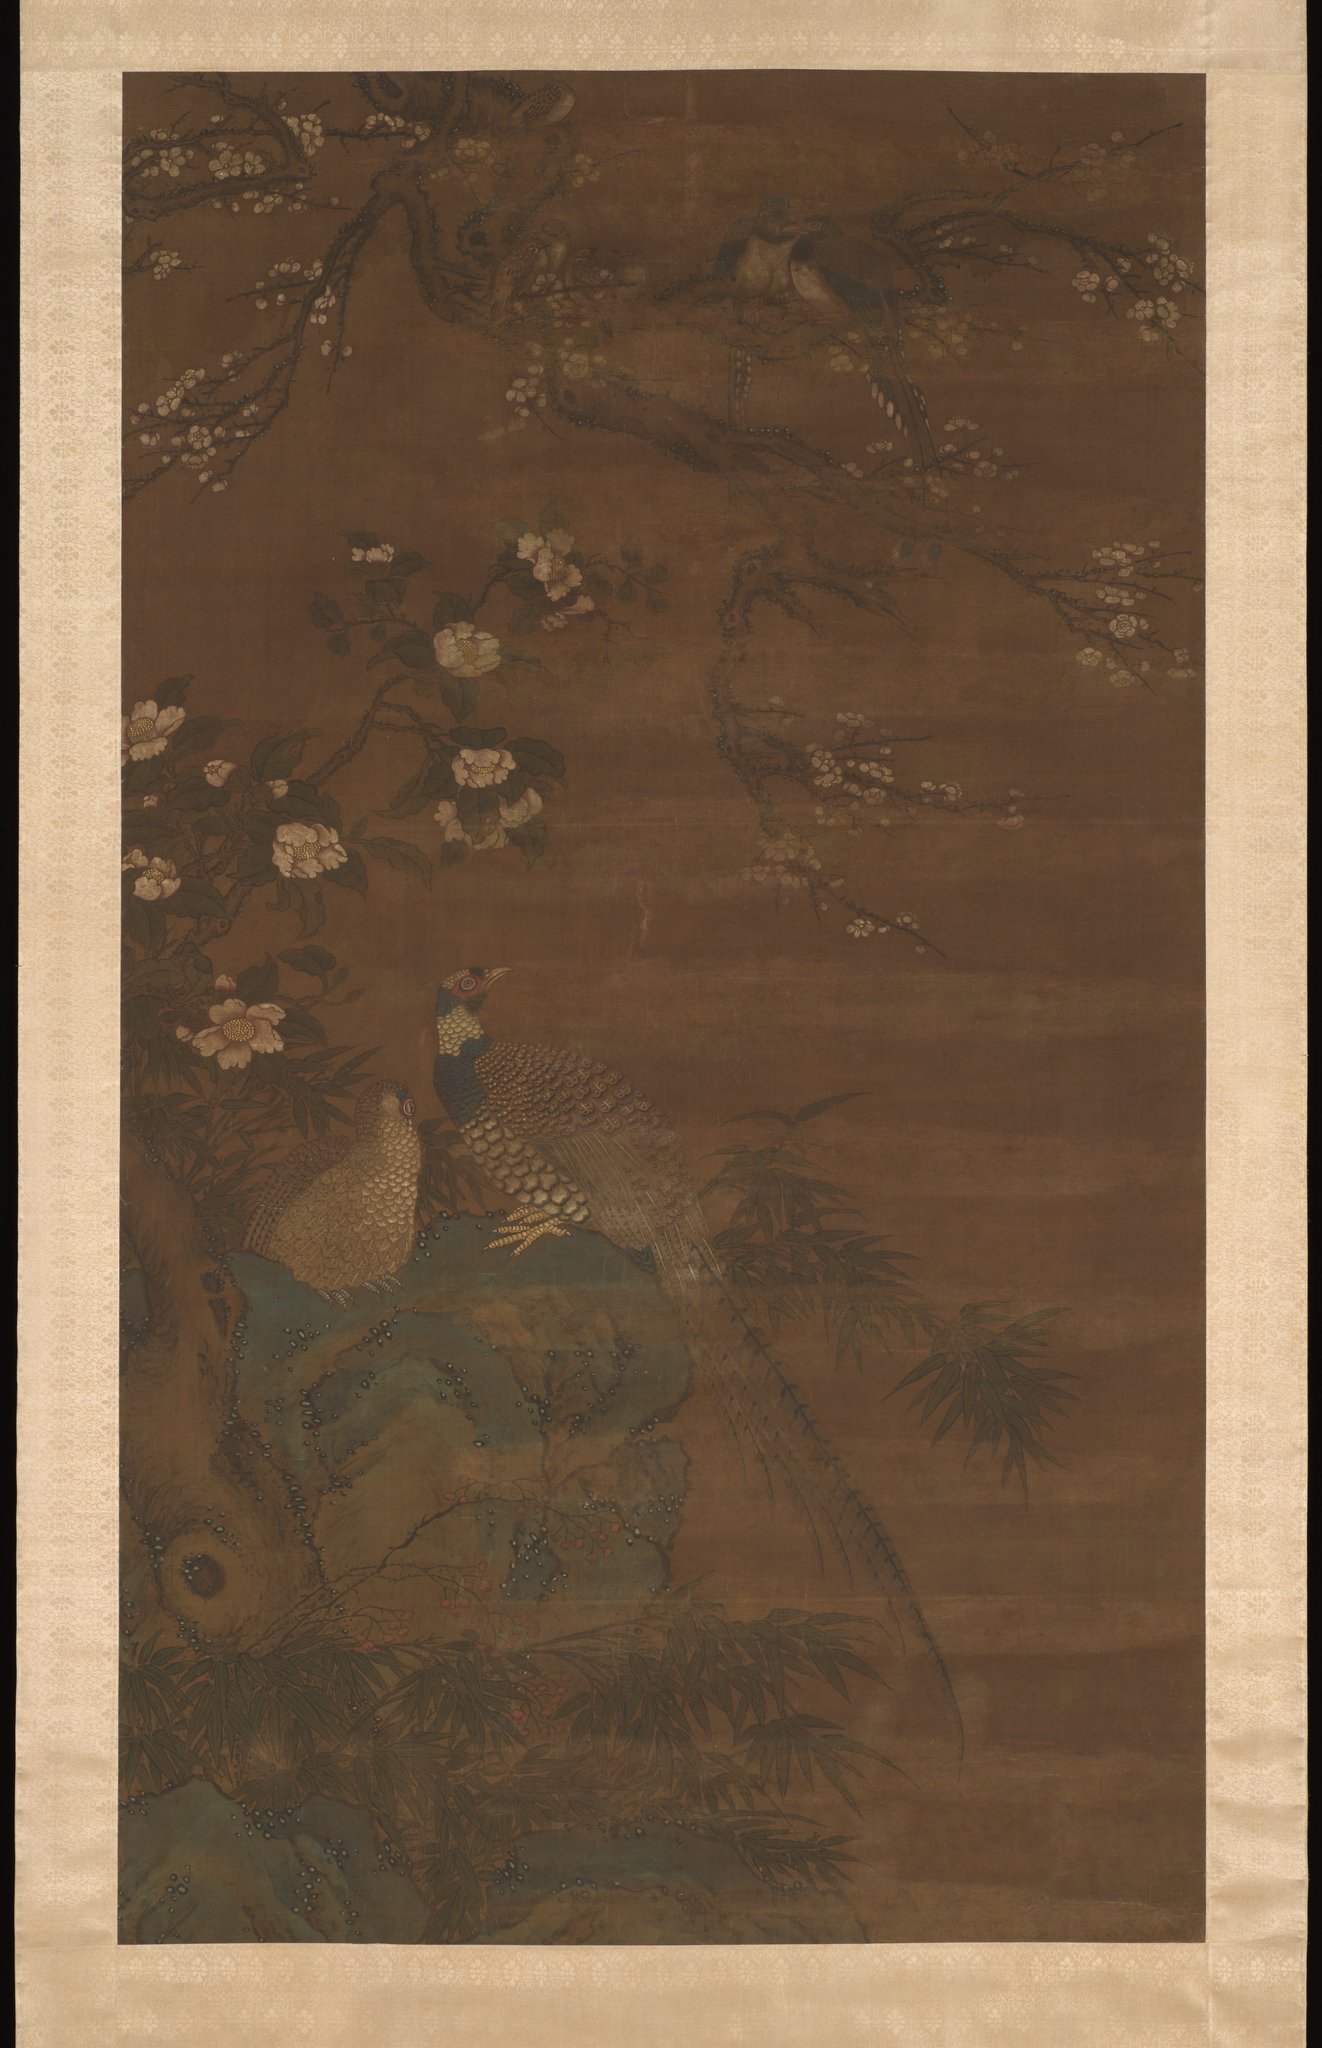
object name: hanging scroll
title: Birds and Flowers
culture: chinese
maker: unidentified artist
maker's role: artist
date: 1701-1900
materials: ink, silk